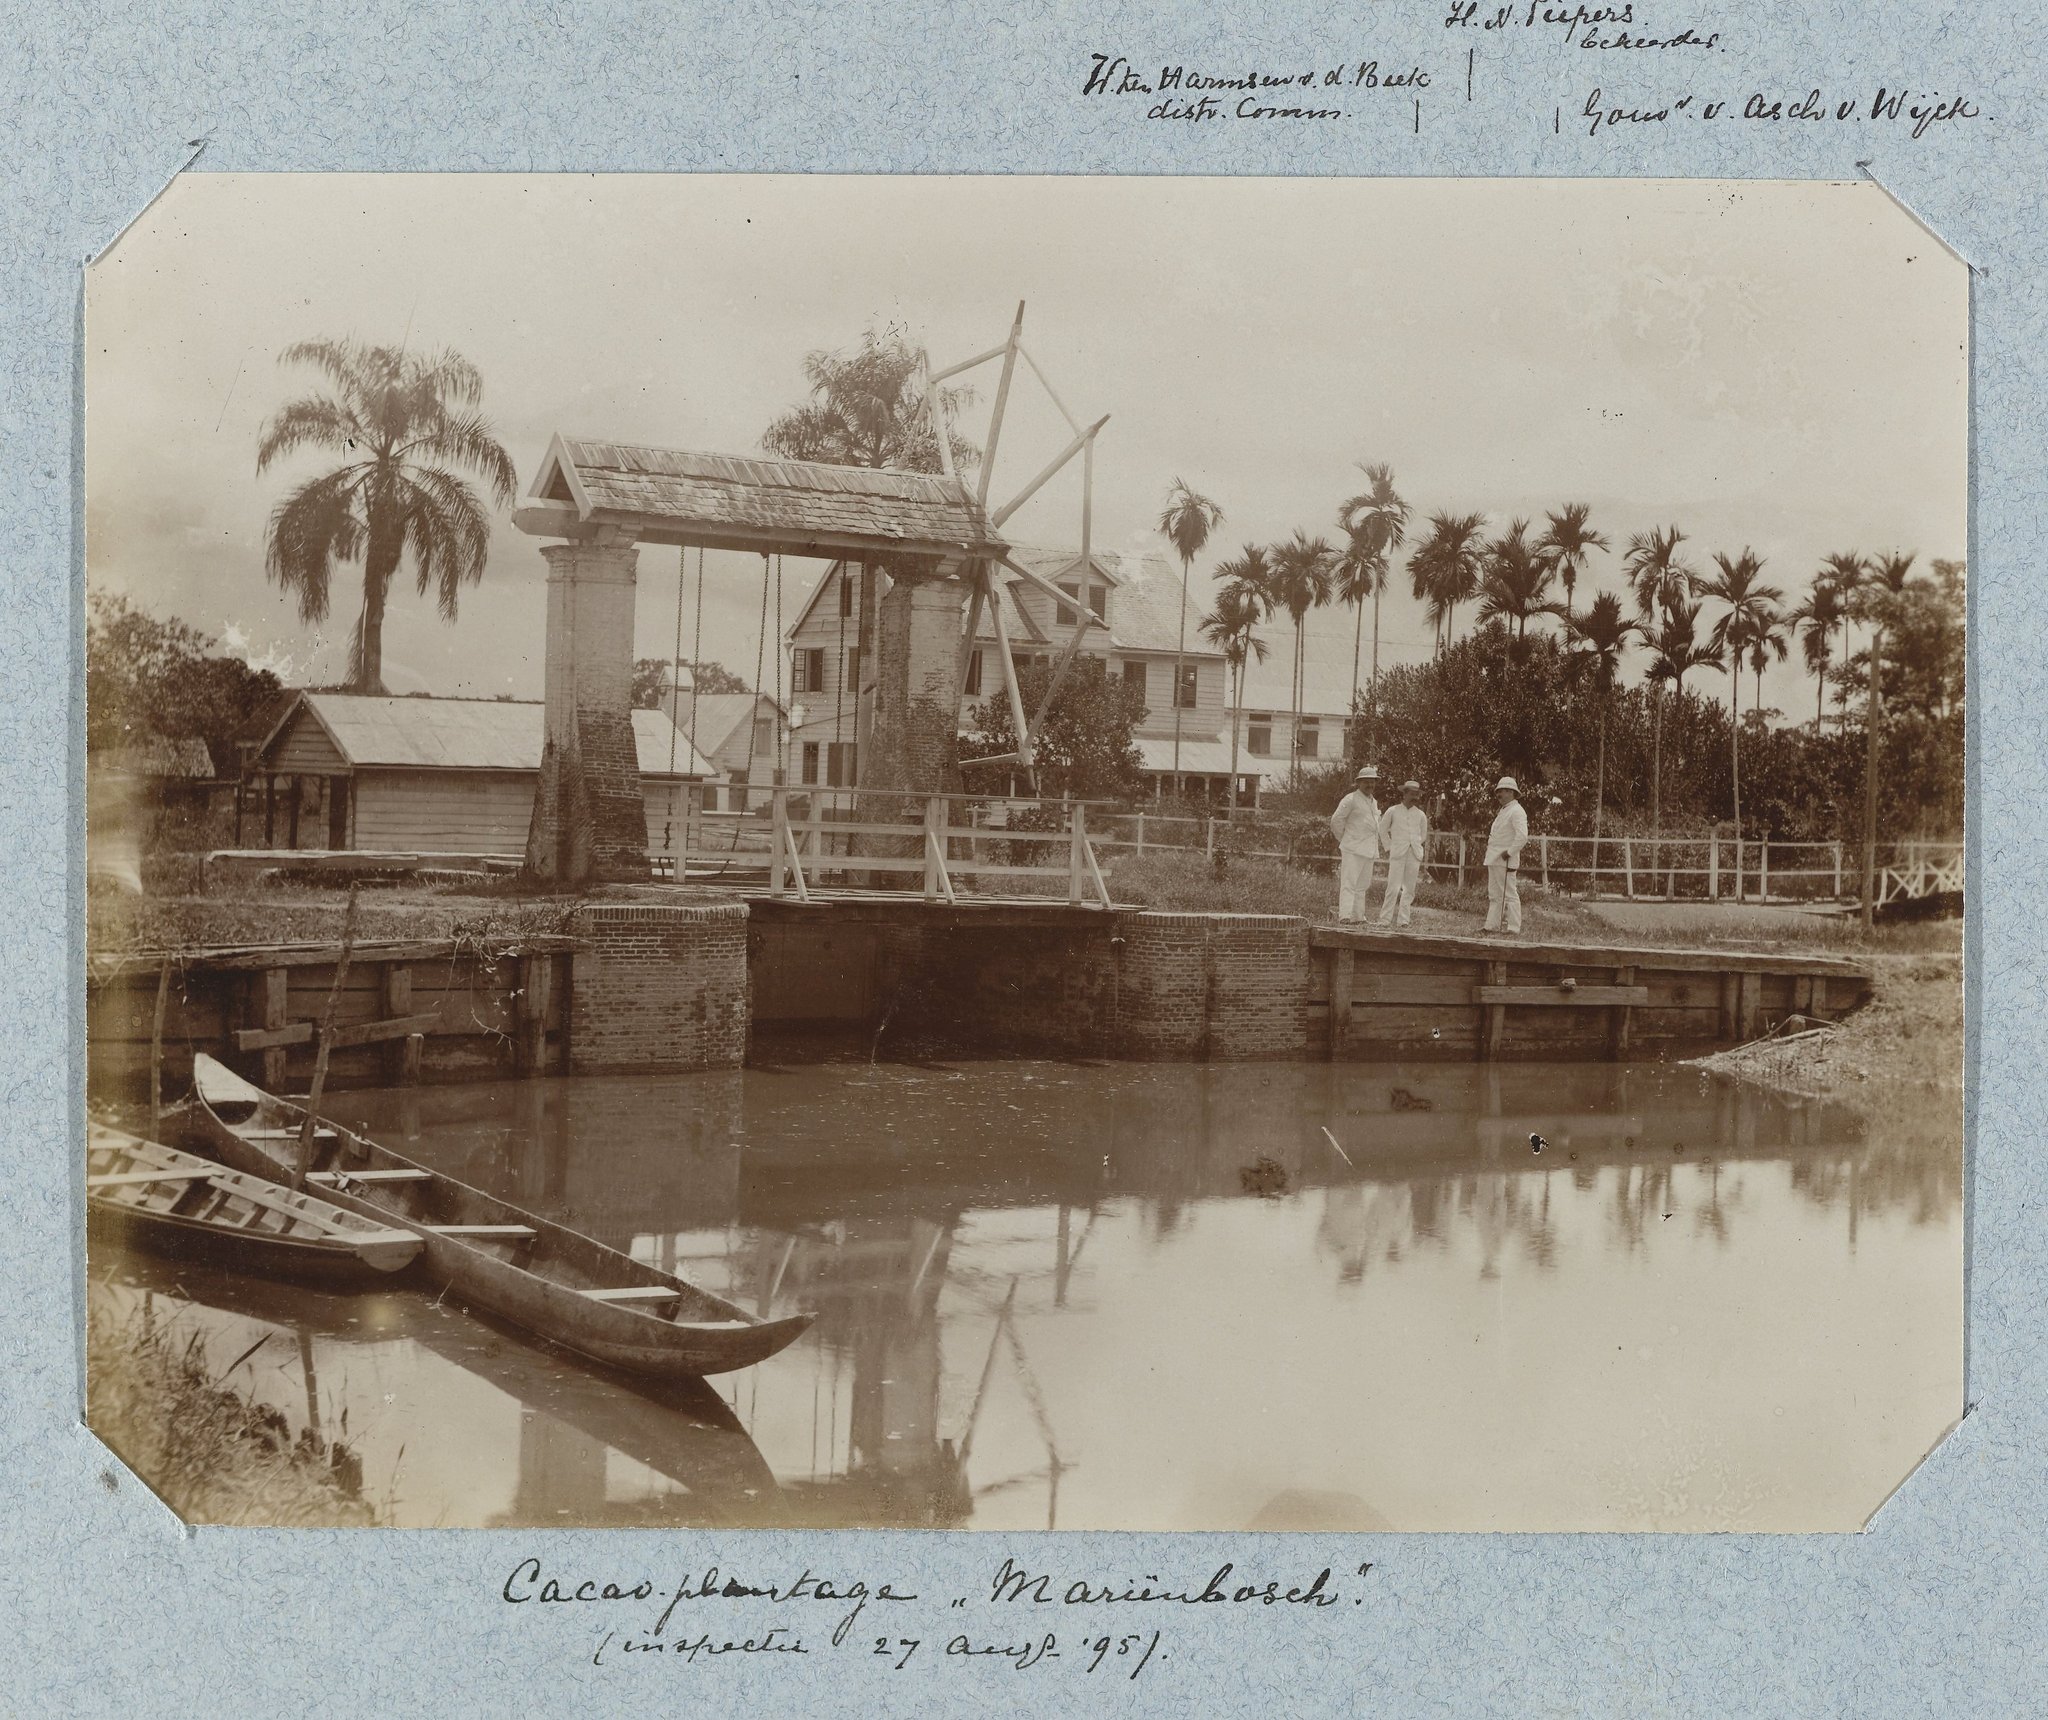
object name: photograph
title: Cacao plantage "Mariënbosch" (inspectie 27 aug.s '95)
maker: théodore van lelyveld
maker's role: painter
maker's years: 1867-1954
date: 1895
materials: photographic support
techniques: collodion silver print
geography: suriname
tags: utrecht, plantation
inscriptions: inscription: ‘Cacao plantage "Mariënbosch" (inspectie 27 aug.s '95) / H. ten Harmsen v.d. Beek. distr. Comm. / H. v. Siepers. beheerder / Gouv.r. v. Asch v. Wijck.’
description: Brug en gebouwen van de cacaoplantage Marienbosch, tijdens een inspectie op 27 augustus 1895. Op de kade bij de bug staan: H. ten Harmsen v.d. Beek. distr. Comm. / H. v. Siepers. beheerder / Gouv.r. v. Asch v. Wijck. Fotoafdruk in een fotoalbum van Théodore van Lelyveld over Suriname uit 1895-1898.